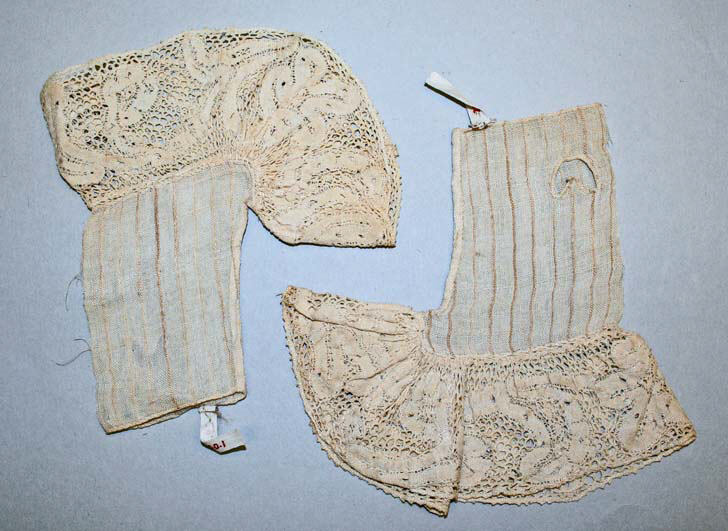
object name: christening mitt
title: Christening mitts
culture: american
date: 1701-1800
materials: cotton, linen